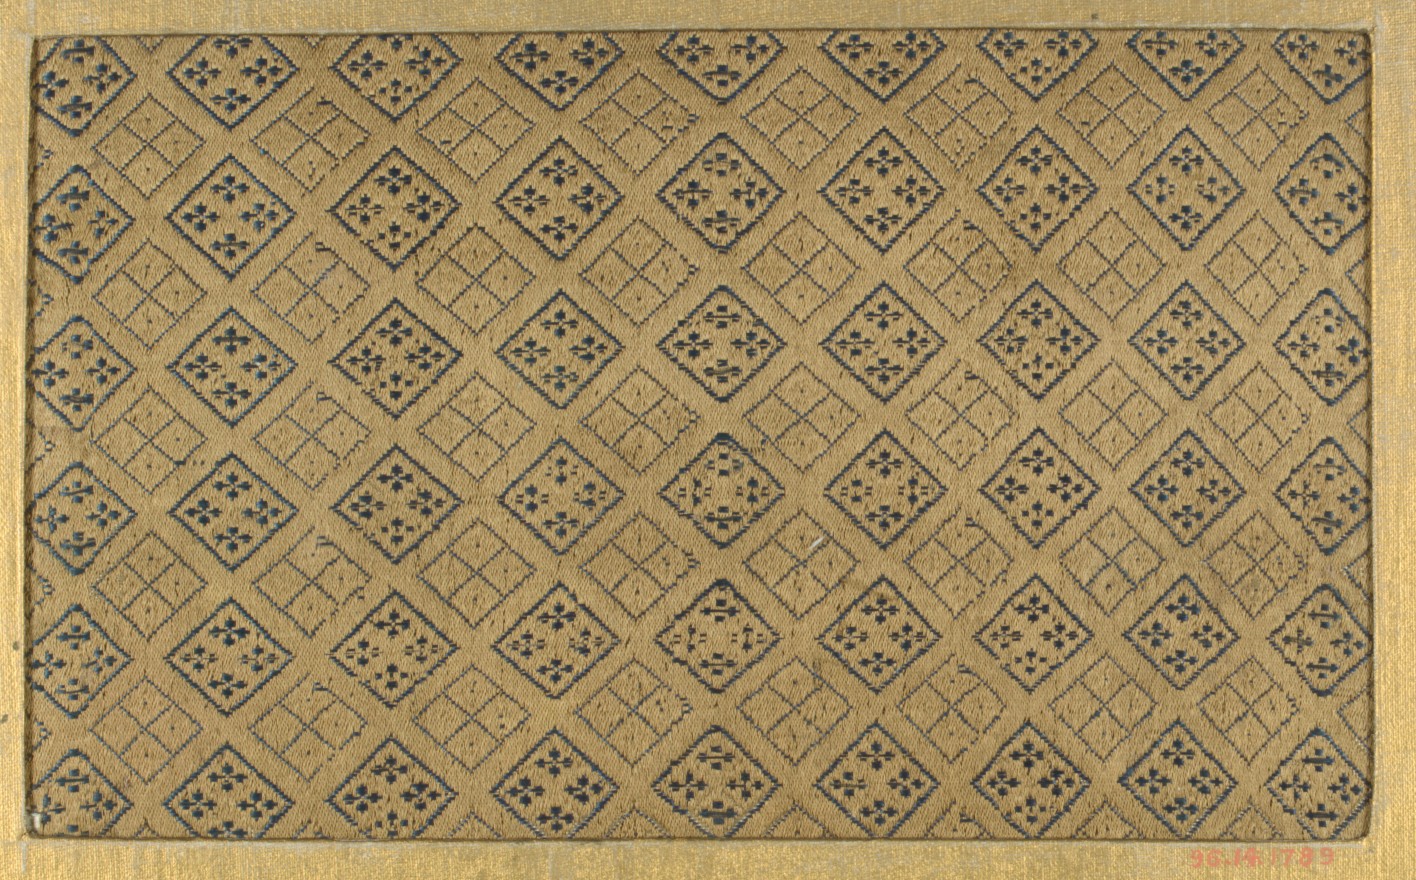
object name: piece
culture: japanese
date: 1701-1900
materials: silk